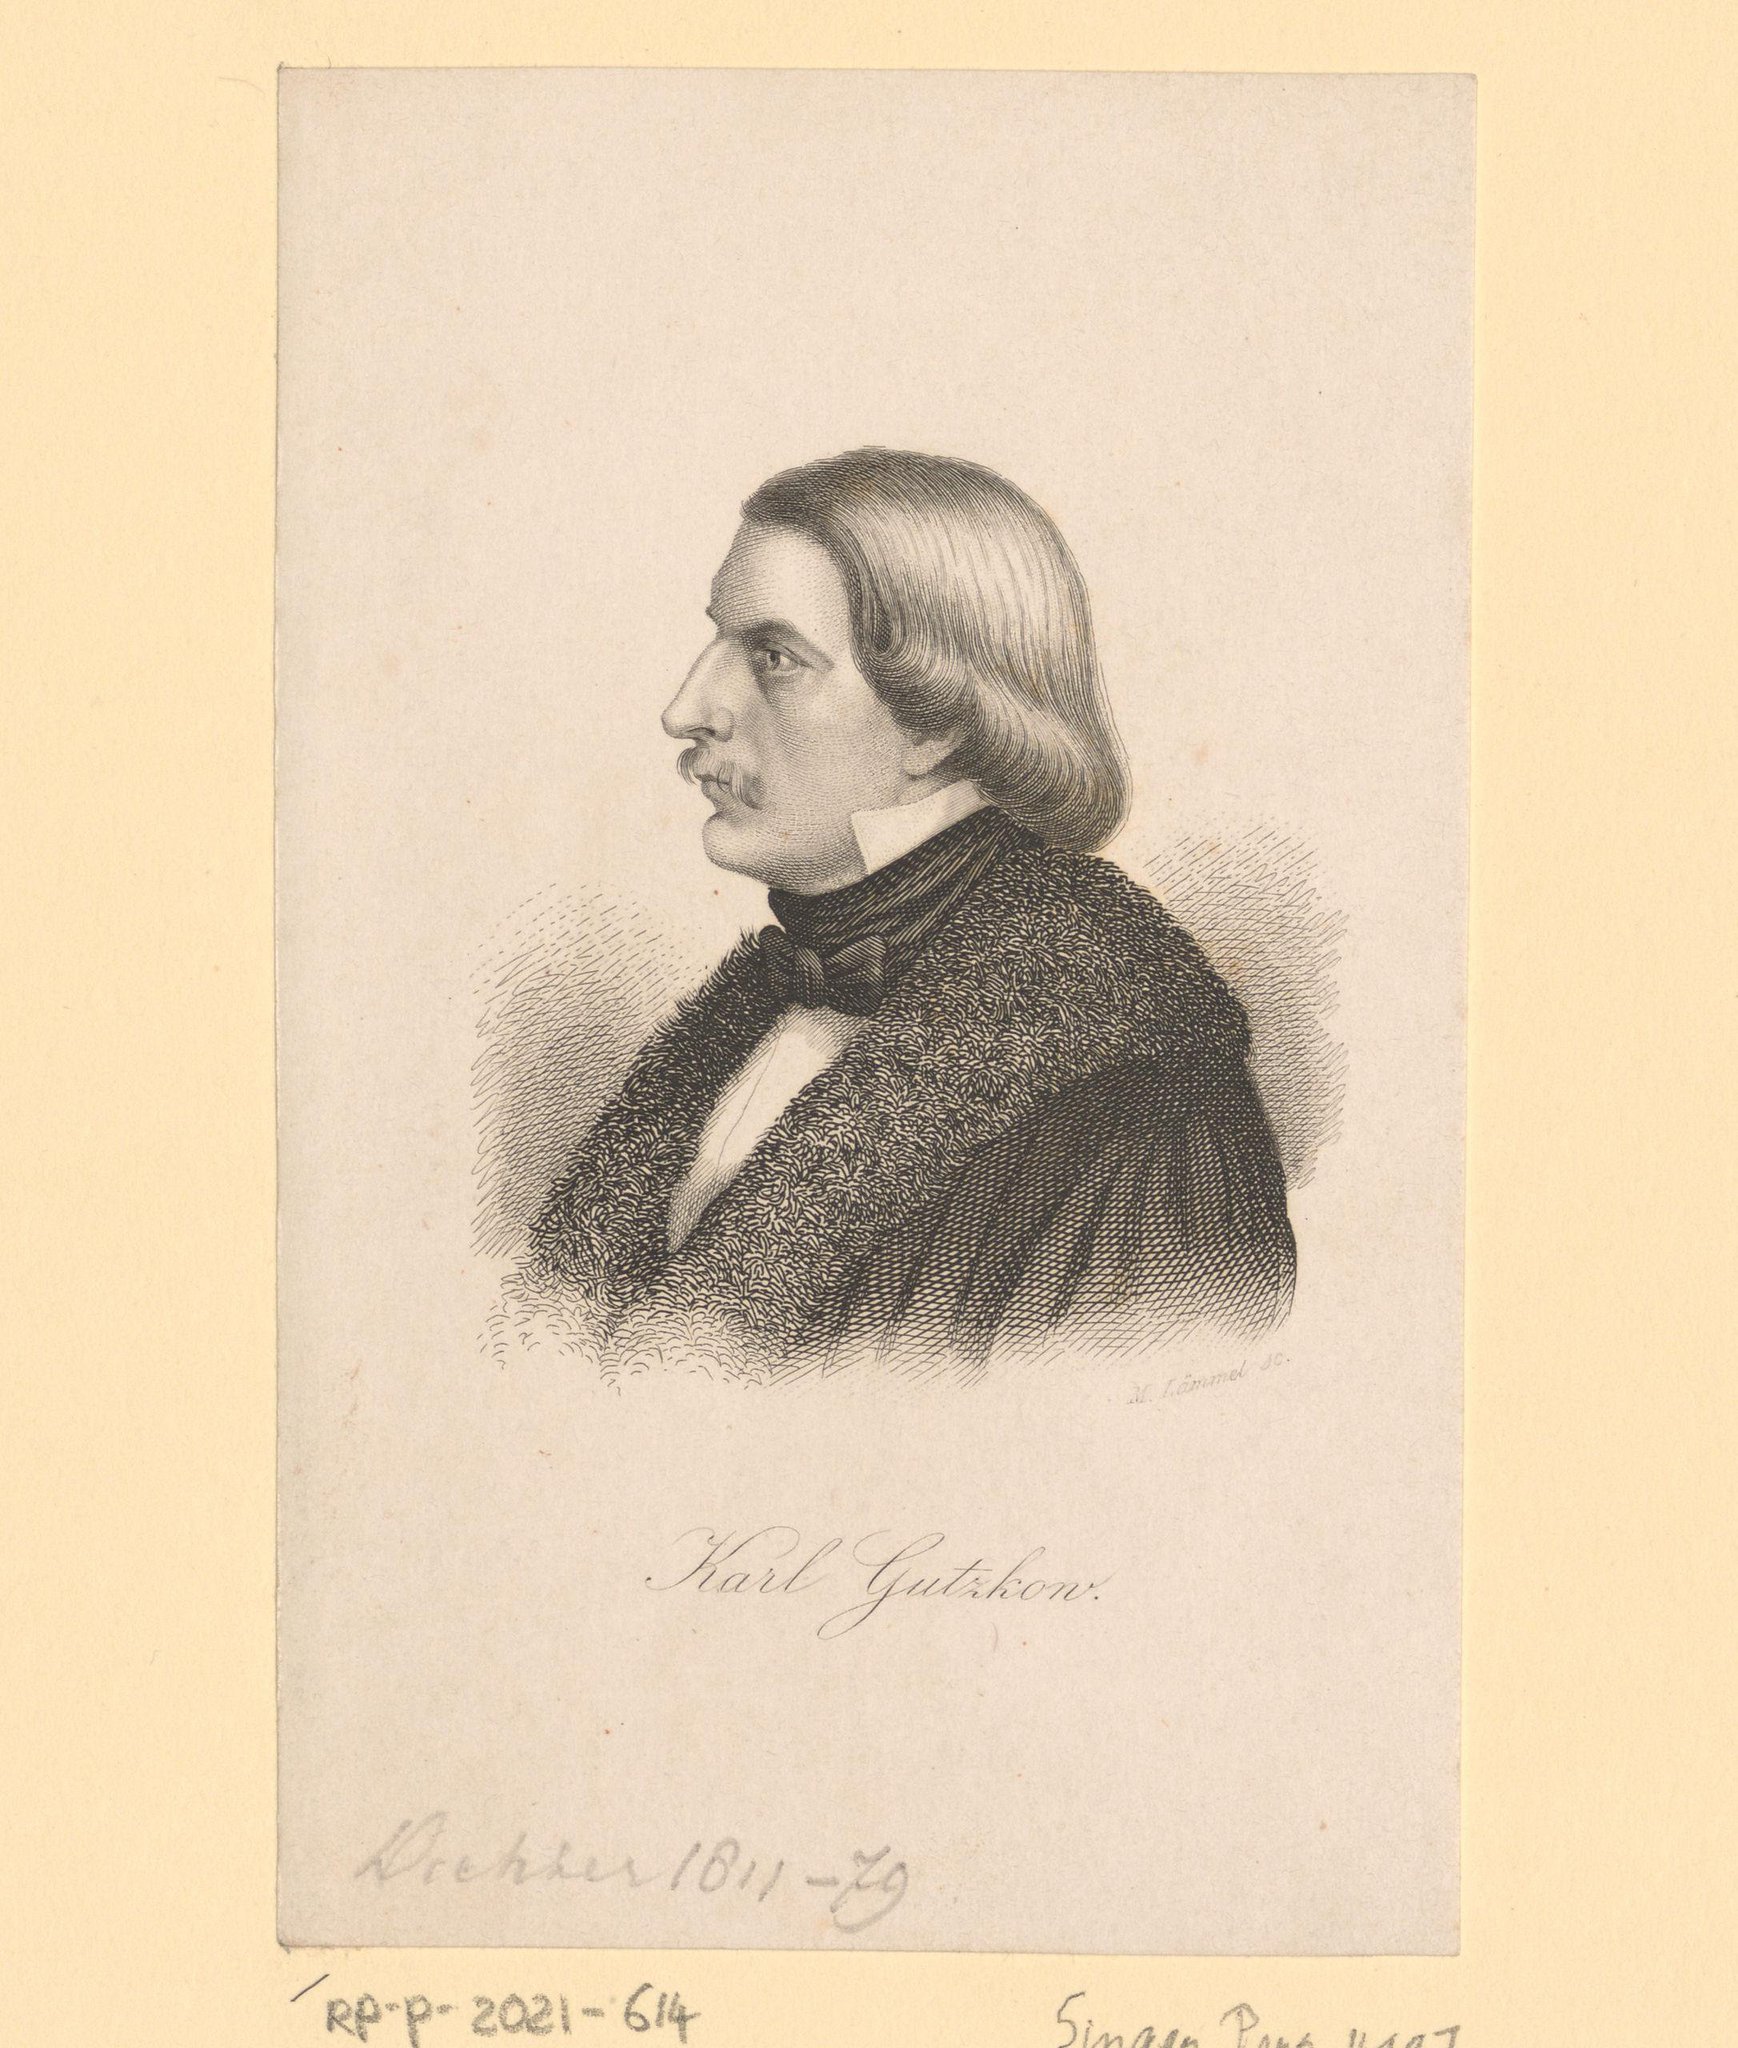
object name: print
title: Portret van Karl Gutzkow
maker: moritz lämmel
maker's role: print maker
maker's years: 1822-1866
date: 1832-1866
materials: paper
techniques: engraving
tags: berlin, historical persons, professor